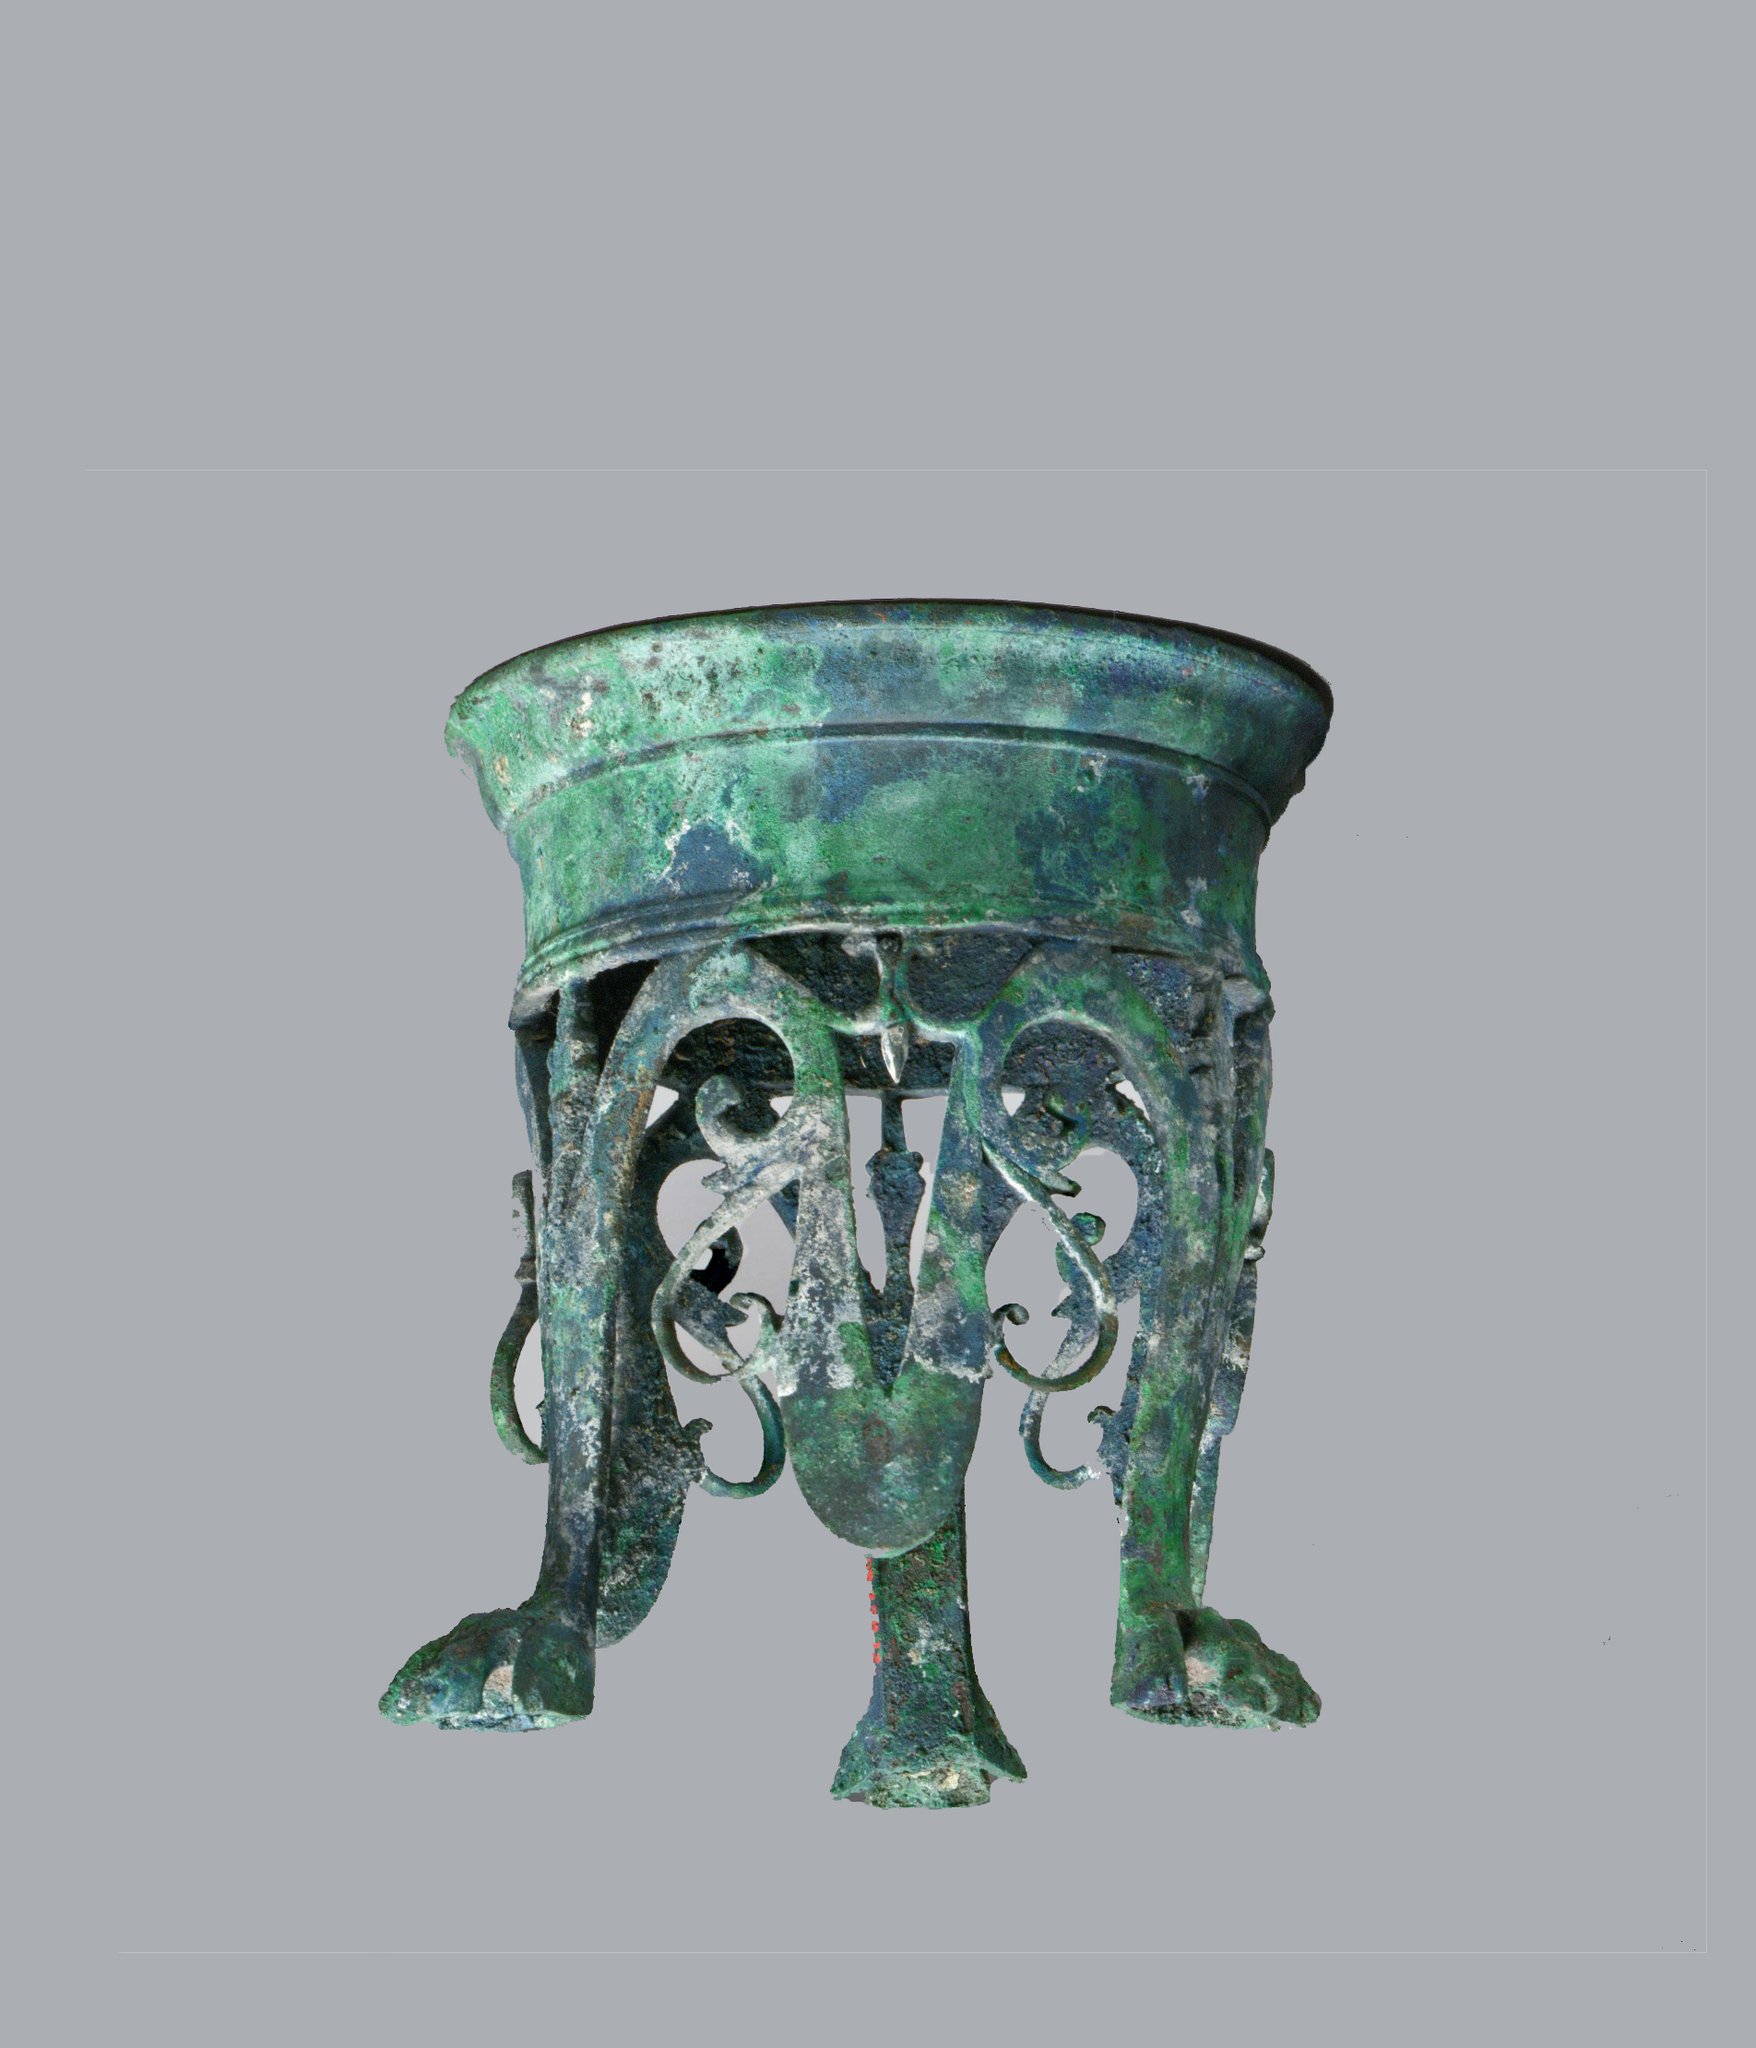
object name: lampstand or tripod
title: Bronze stand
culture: roman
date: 1-100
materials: bronze